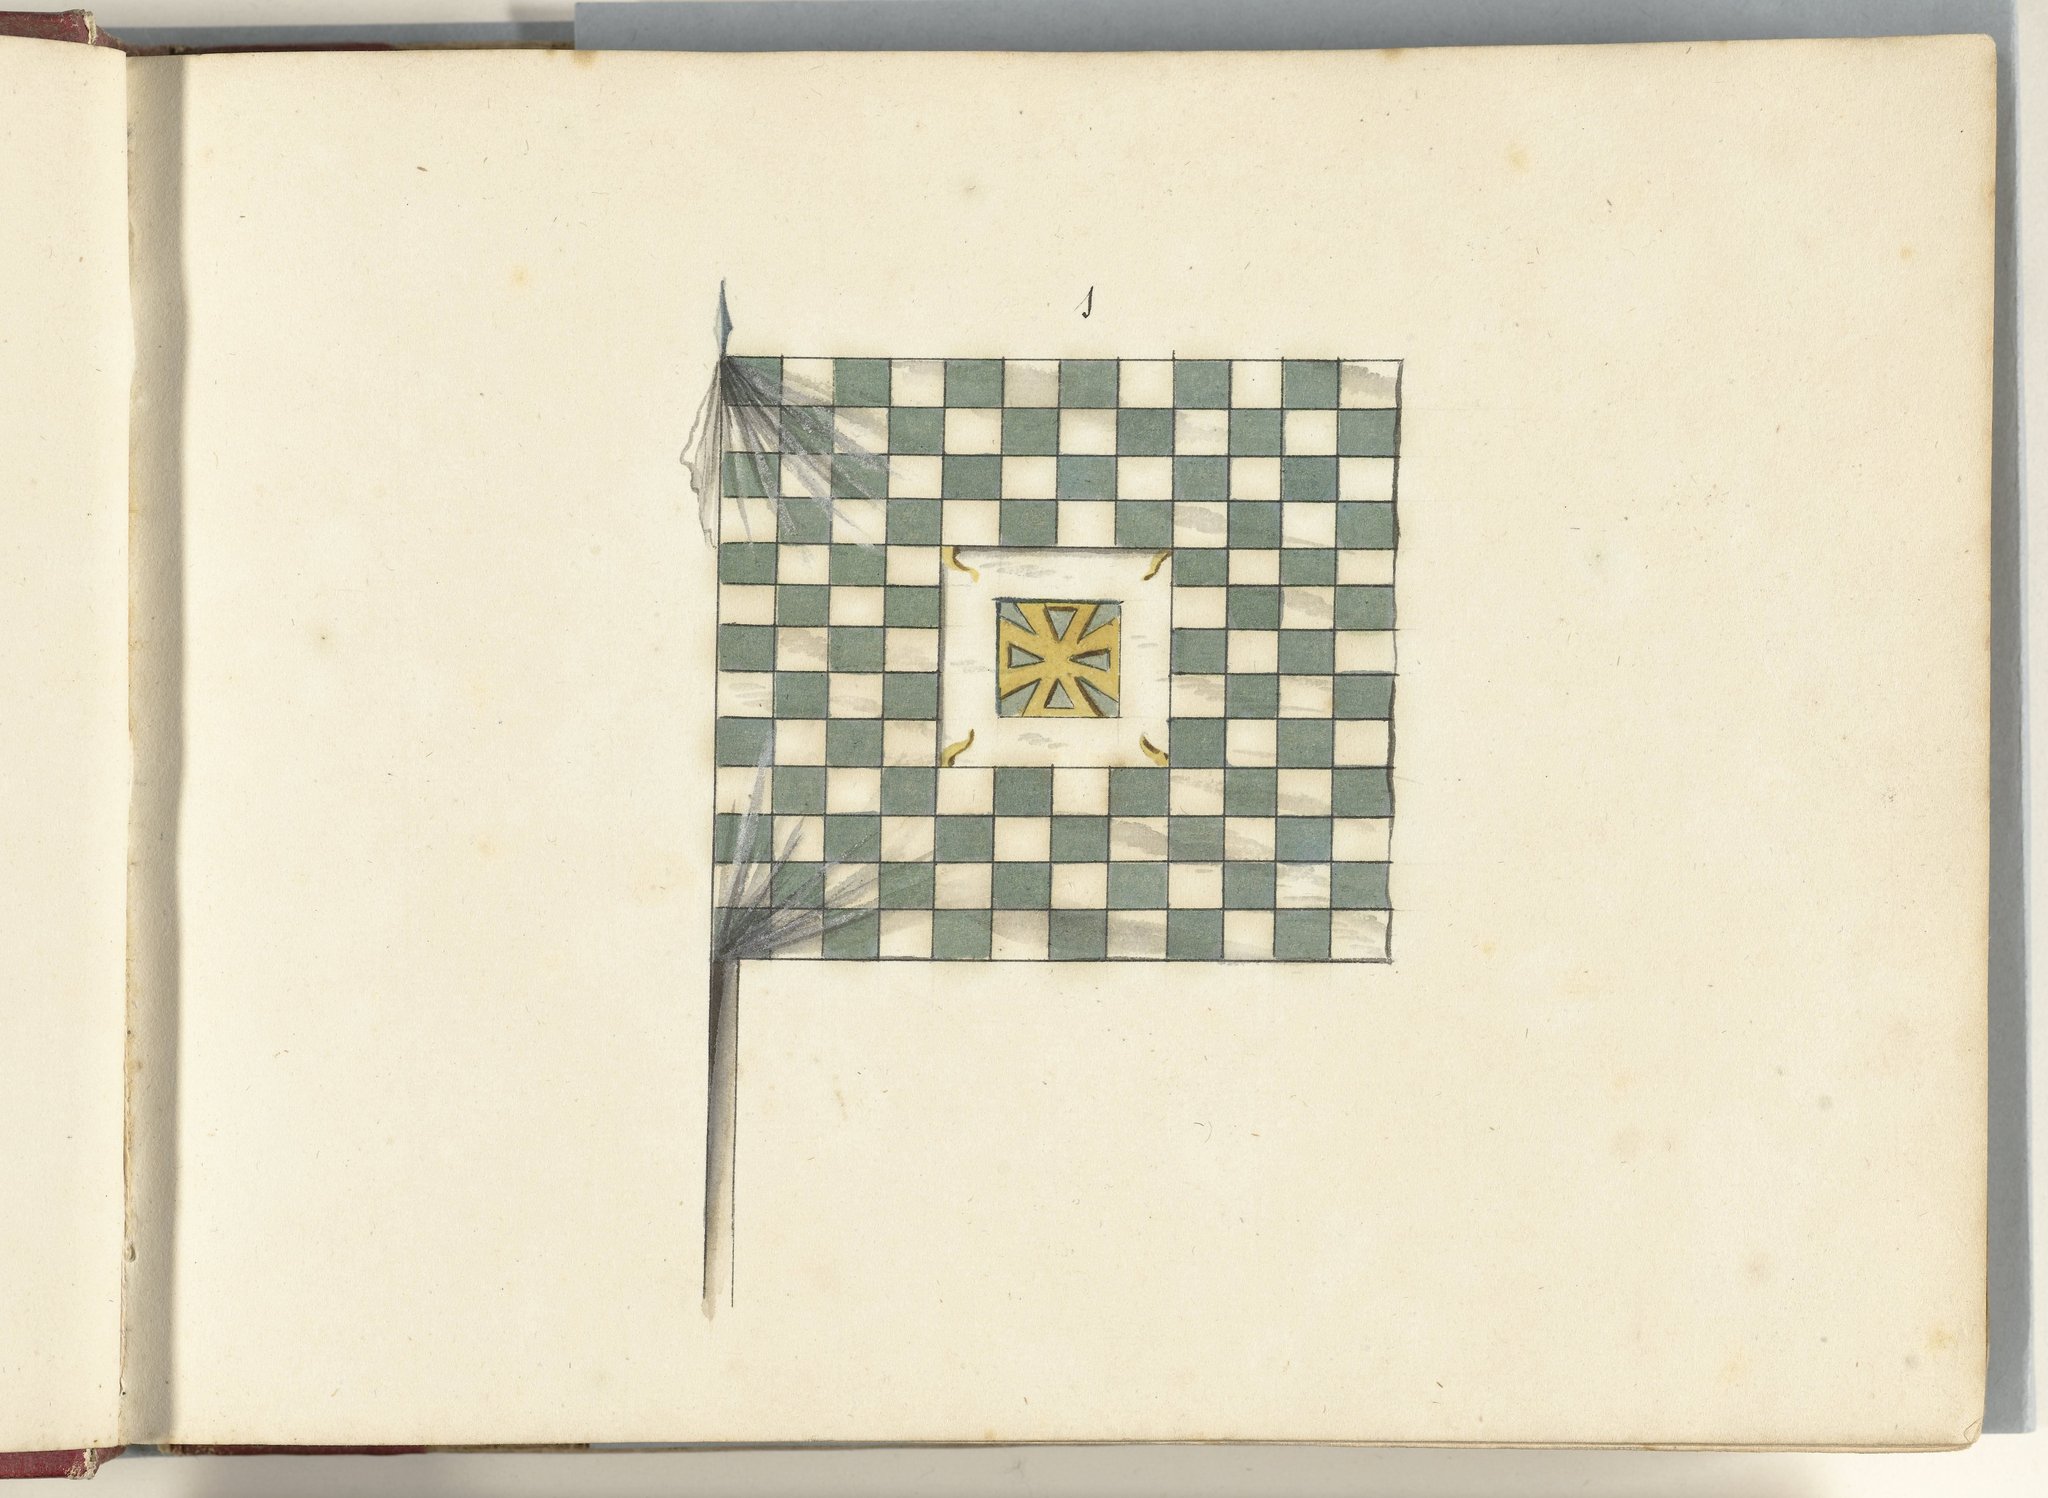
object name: drawing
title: Frans vaandel veroverd in de slag bij Spierbach, 1703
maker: Anonymous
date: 1713-1720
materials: paper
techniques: drawing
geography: northern netherlands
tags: (military) flags and standards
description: Frans vaandel veroverd in de slag bij Spierbach, 1703. In het boek met tekeningen van Franse vaandels, standaarden en pauken, veroverd tijdens de Spaanse Successieoorlog (1701-1713).